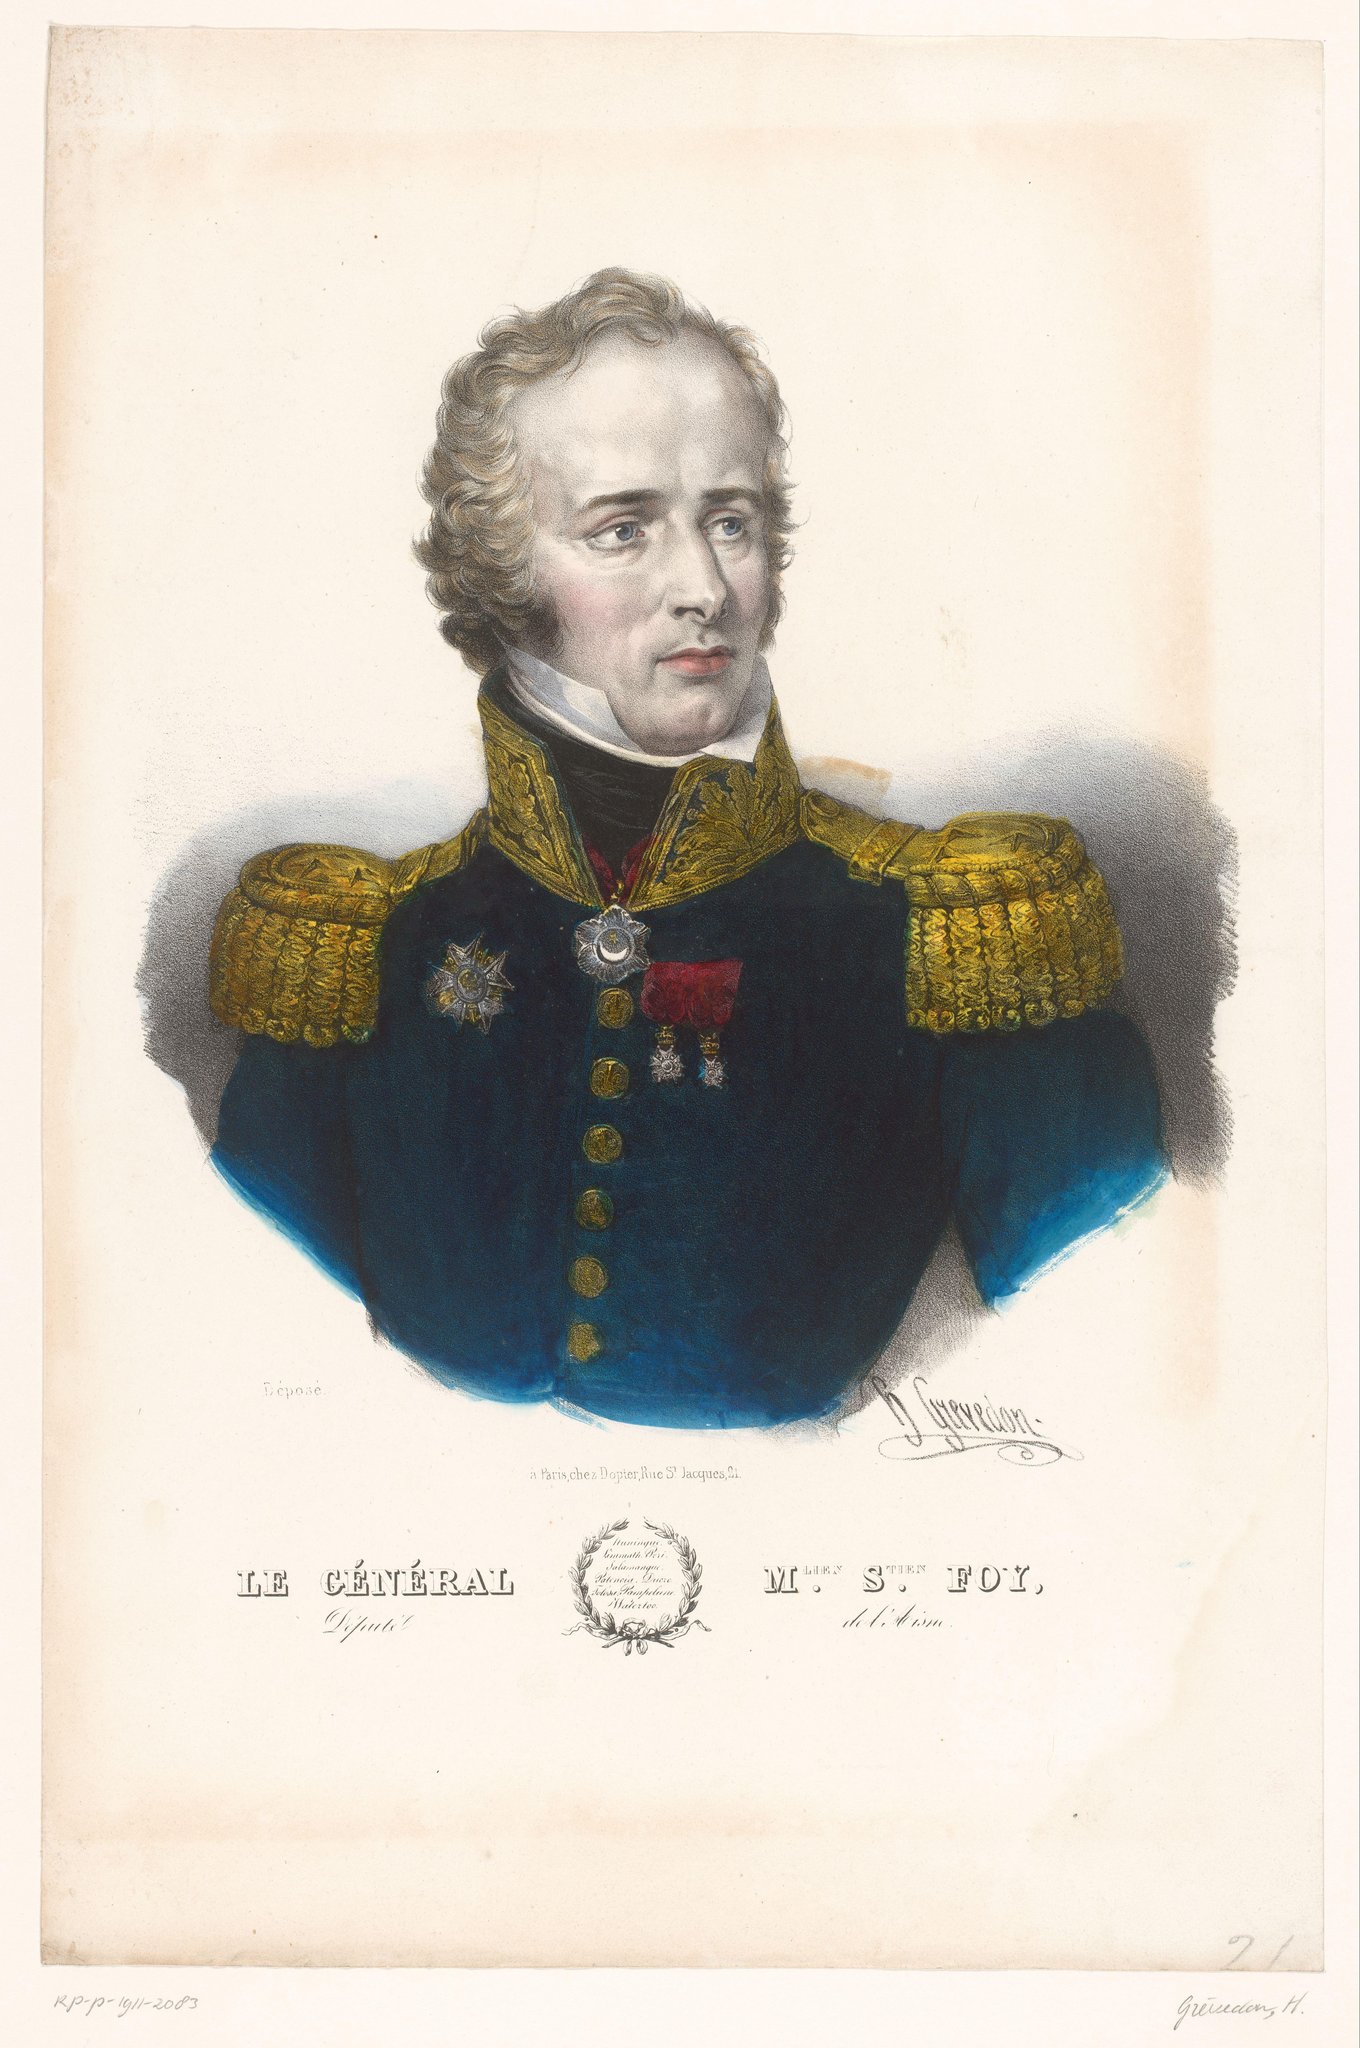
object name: print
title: Le Général M.lien S.tien Foy, député de l'Aisne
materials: paper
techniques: hand coloring, lithograph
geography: paris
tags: paris, politician, maximilien sébastien foy, historical persons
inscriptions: collector's mark: Lugt 2228a